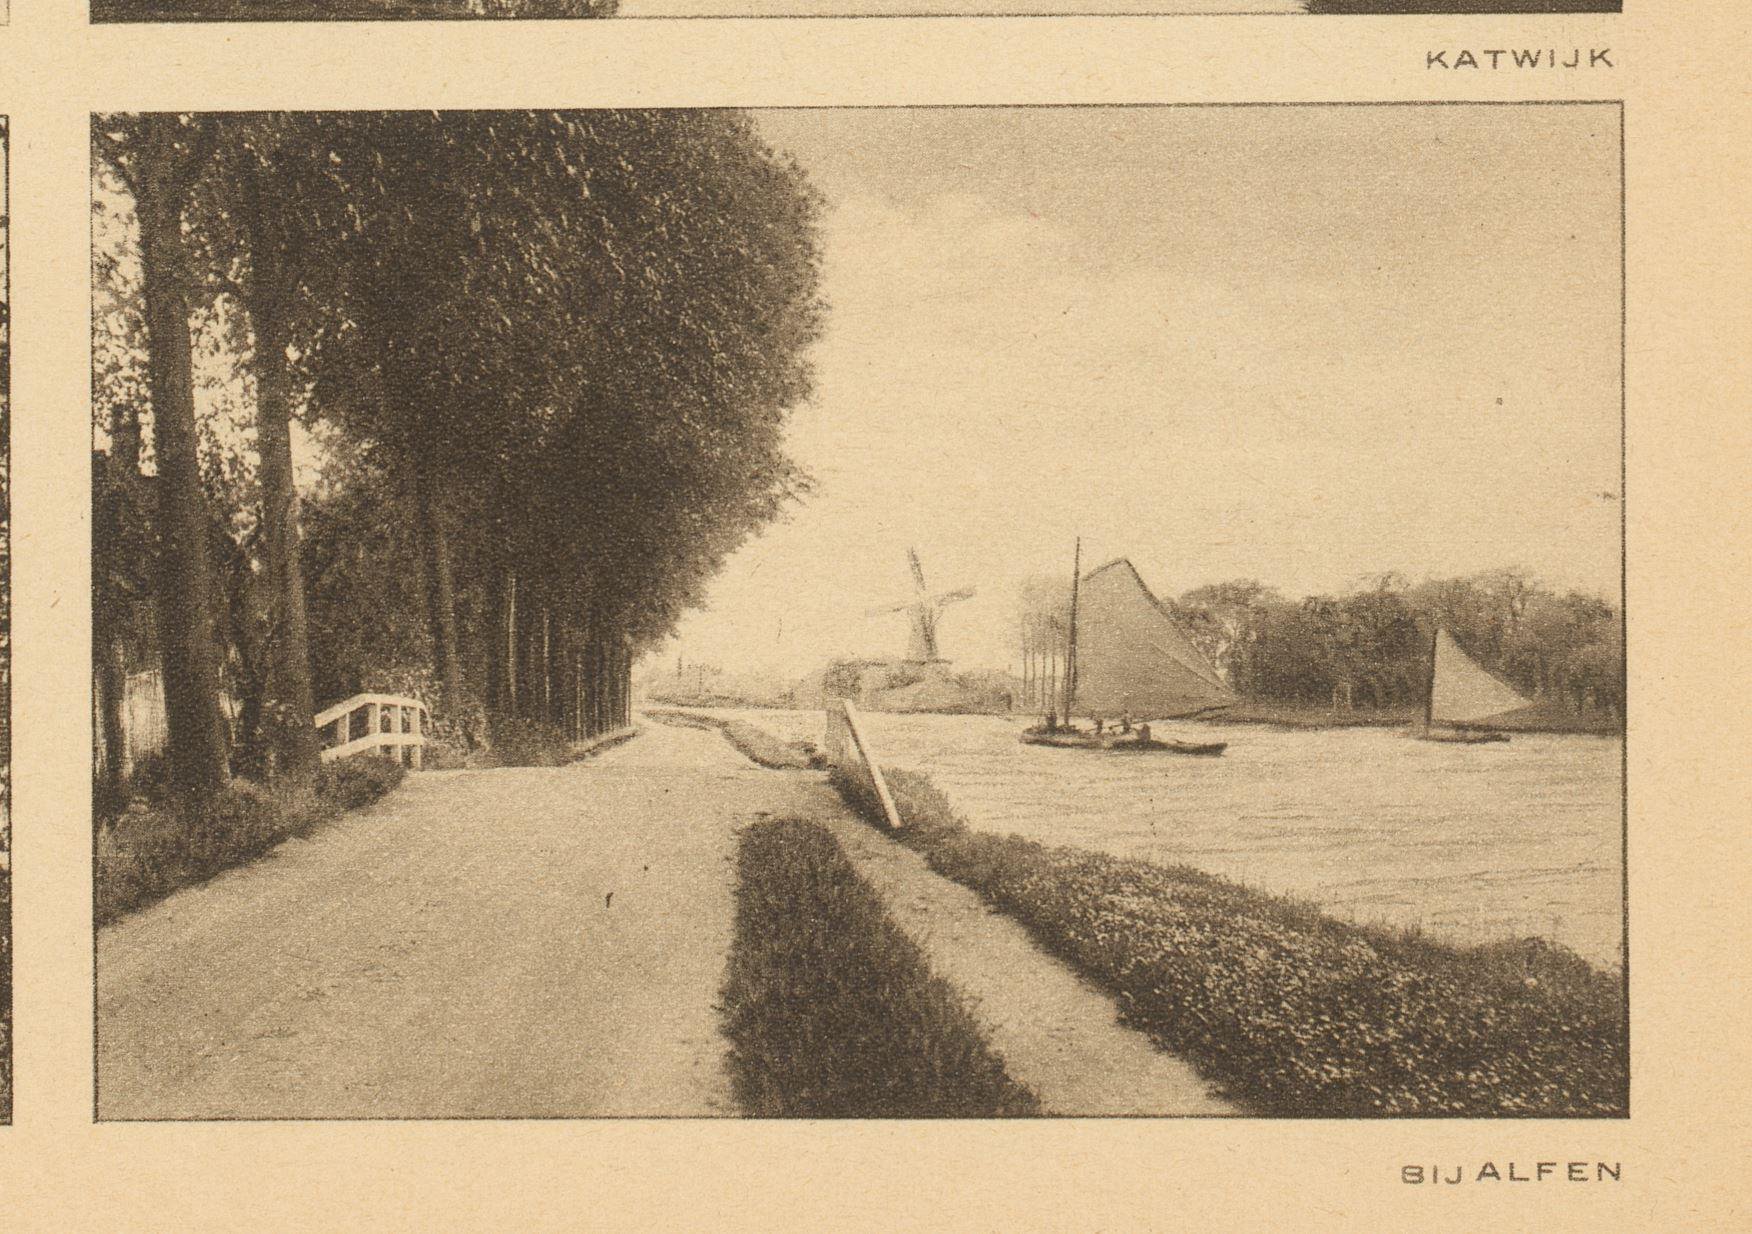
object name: album leaf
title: Bij Alfen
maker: Anonymous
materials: paper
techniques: rotogravure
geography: leiden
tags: sailing-ship, sailing-boat, river, road, path, windmill in landscape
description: Deze prent maakt deel uit van een album.